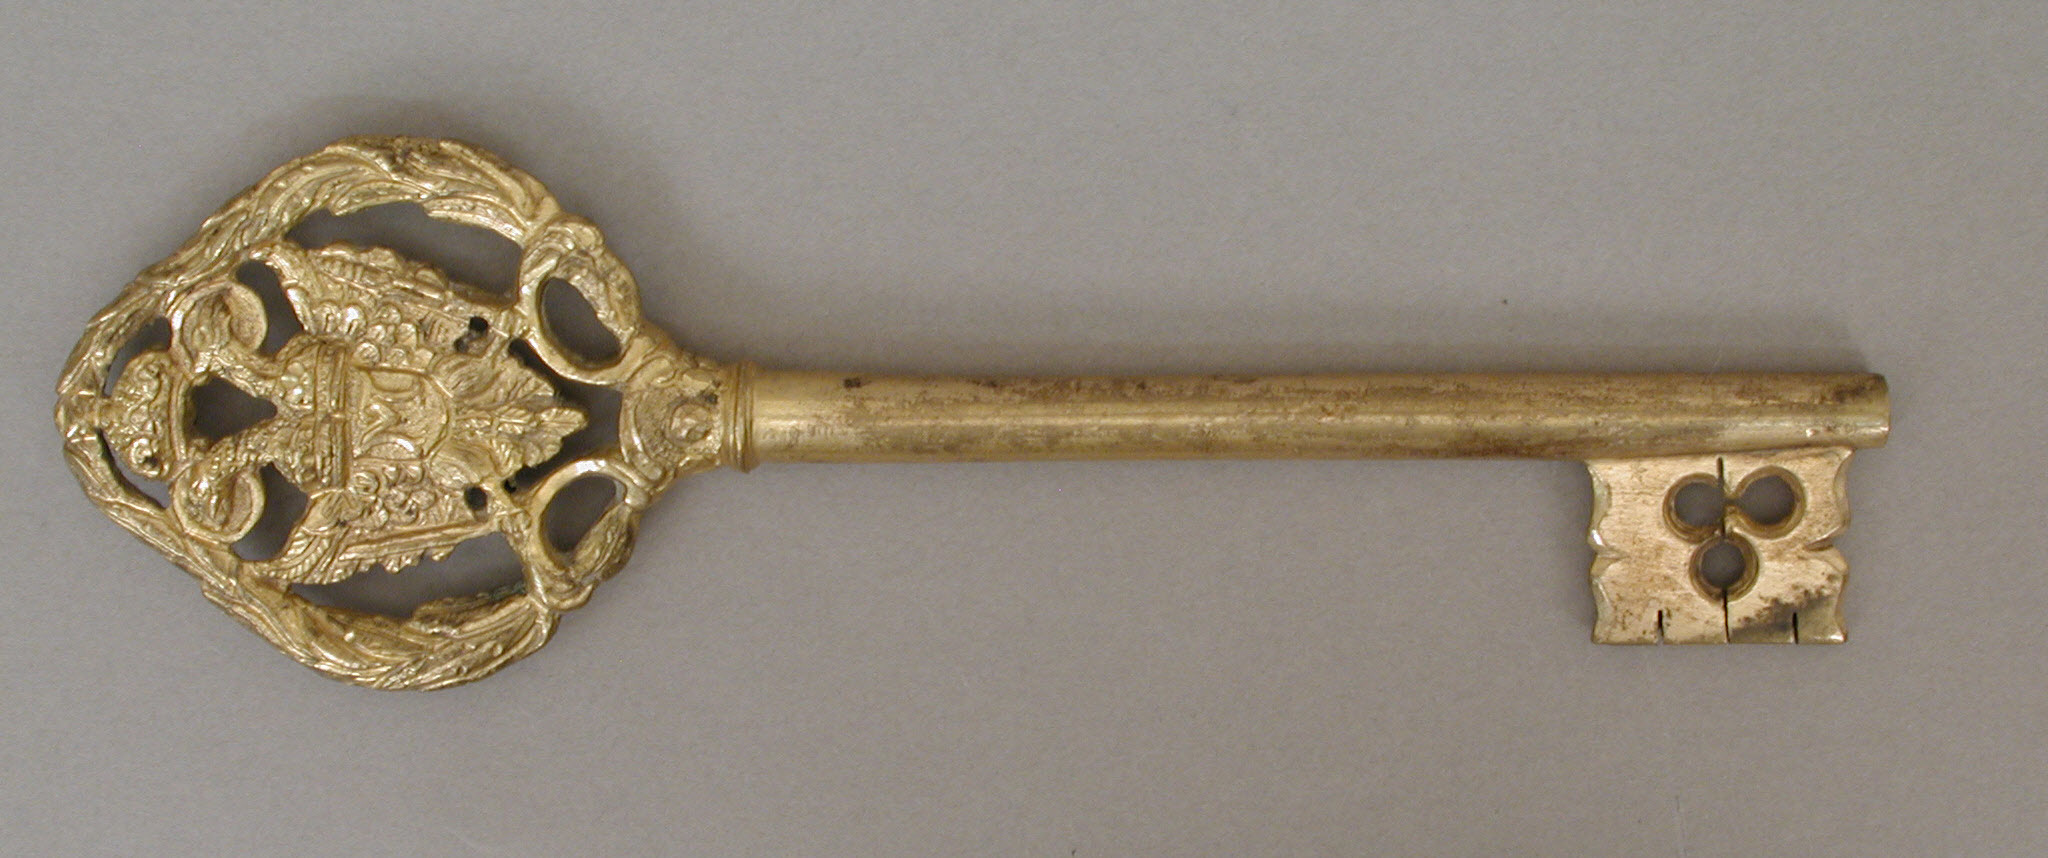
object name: key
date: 1701-1800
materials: gilt bronze